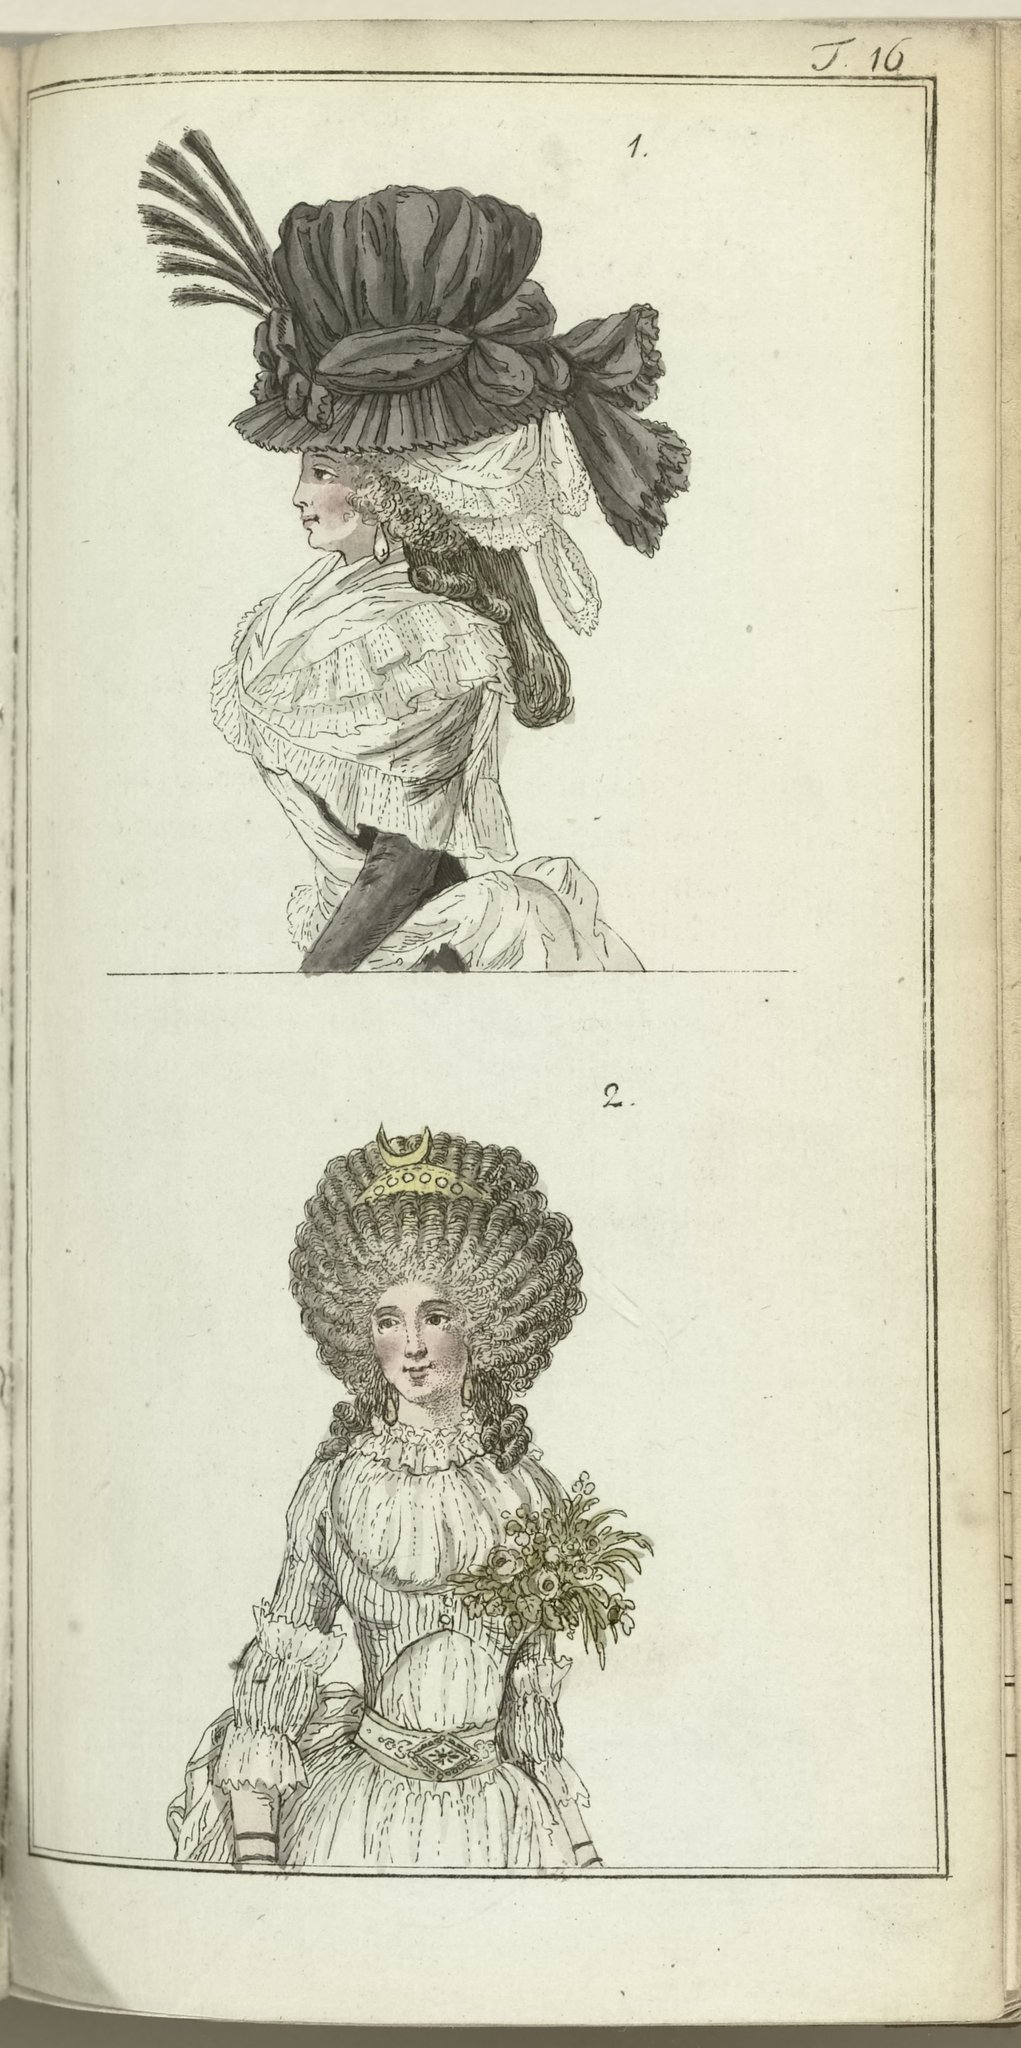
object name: magazine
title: Journal des Luxus und der Moden 1790, Band V, T.16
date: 1790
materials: paper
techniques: etching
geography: weimar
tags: fashion plates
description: Prent uit het modetijdschrift Journal des Luxus und der Moden, uitgegeven door Friedrich Justin Bertuch en Georg Melchior Kraus, Weimar, 1786-1826.